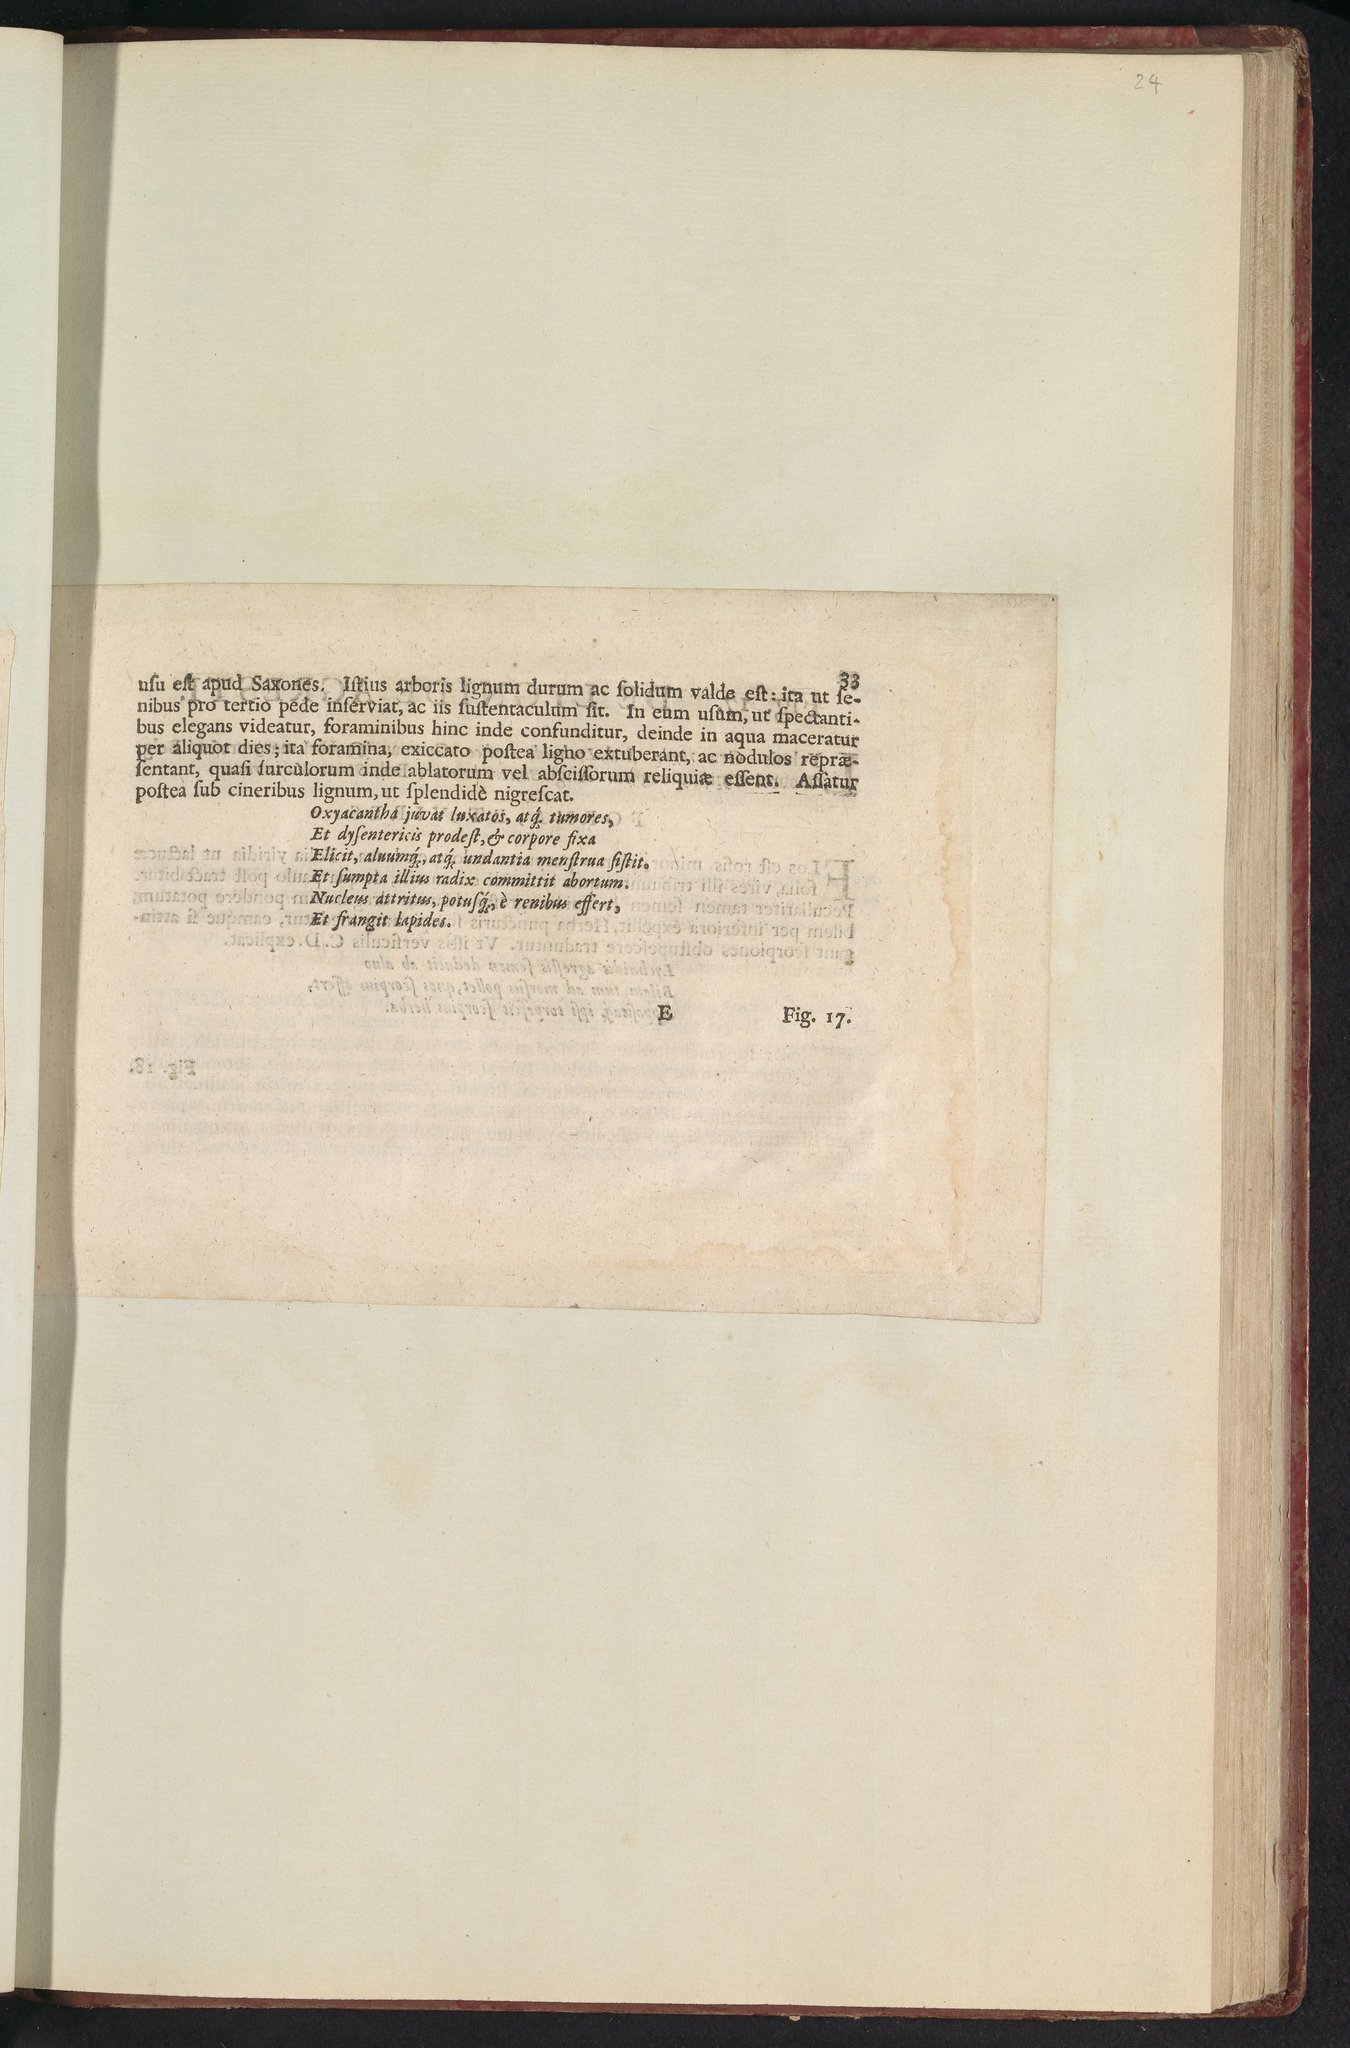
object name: text sheet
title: Fig. 16 'De Acvta Spina' in De Boodts herbarium van 1640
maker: anselmus boëtius de boodt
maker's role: draughtsman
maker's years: 1550-1632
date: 1640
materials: ink, paper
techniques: letterpress printing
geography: bruges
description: Beschrijving bij Fig. 16 op p. 33 in: Anselmi Boëtii de Boot I.C. Brugensis & Rodolphi II. Imp. Roman. medici a cubiculis Florum, Herbarum, ac fructuum selectiorum icones, & vires pleraeque hactenus ignotæ. Onderdeel van het album met bladen en platen uit De Boodts herbarium van 1640. Het twaalfde van twaalf albums met aquarellen van dieren, vogels en planten bekend rond 1600, gemaakt in opdracht van keizer Rudolf II.